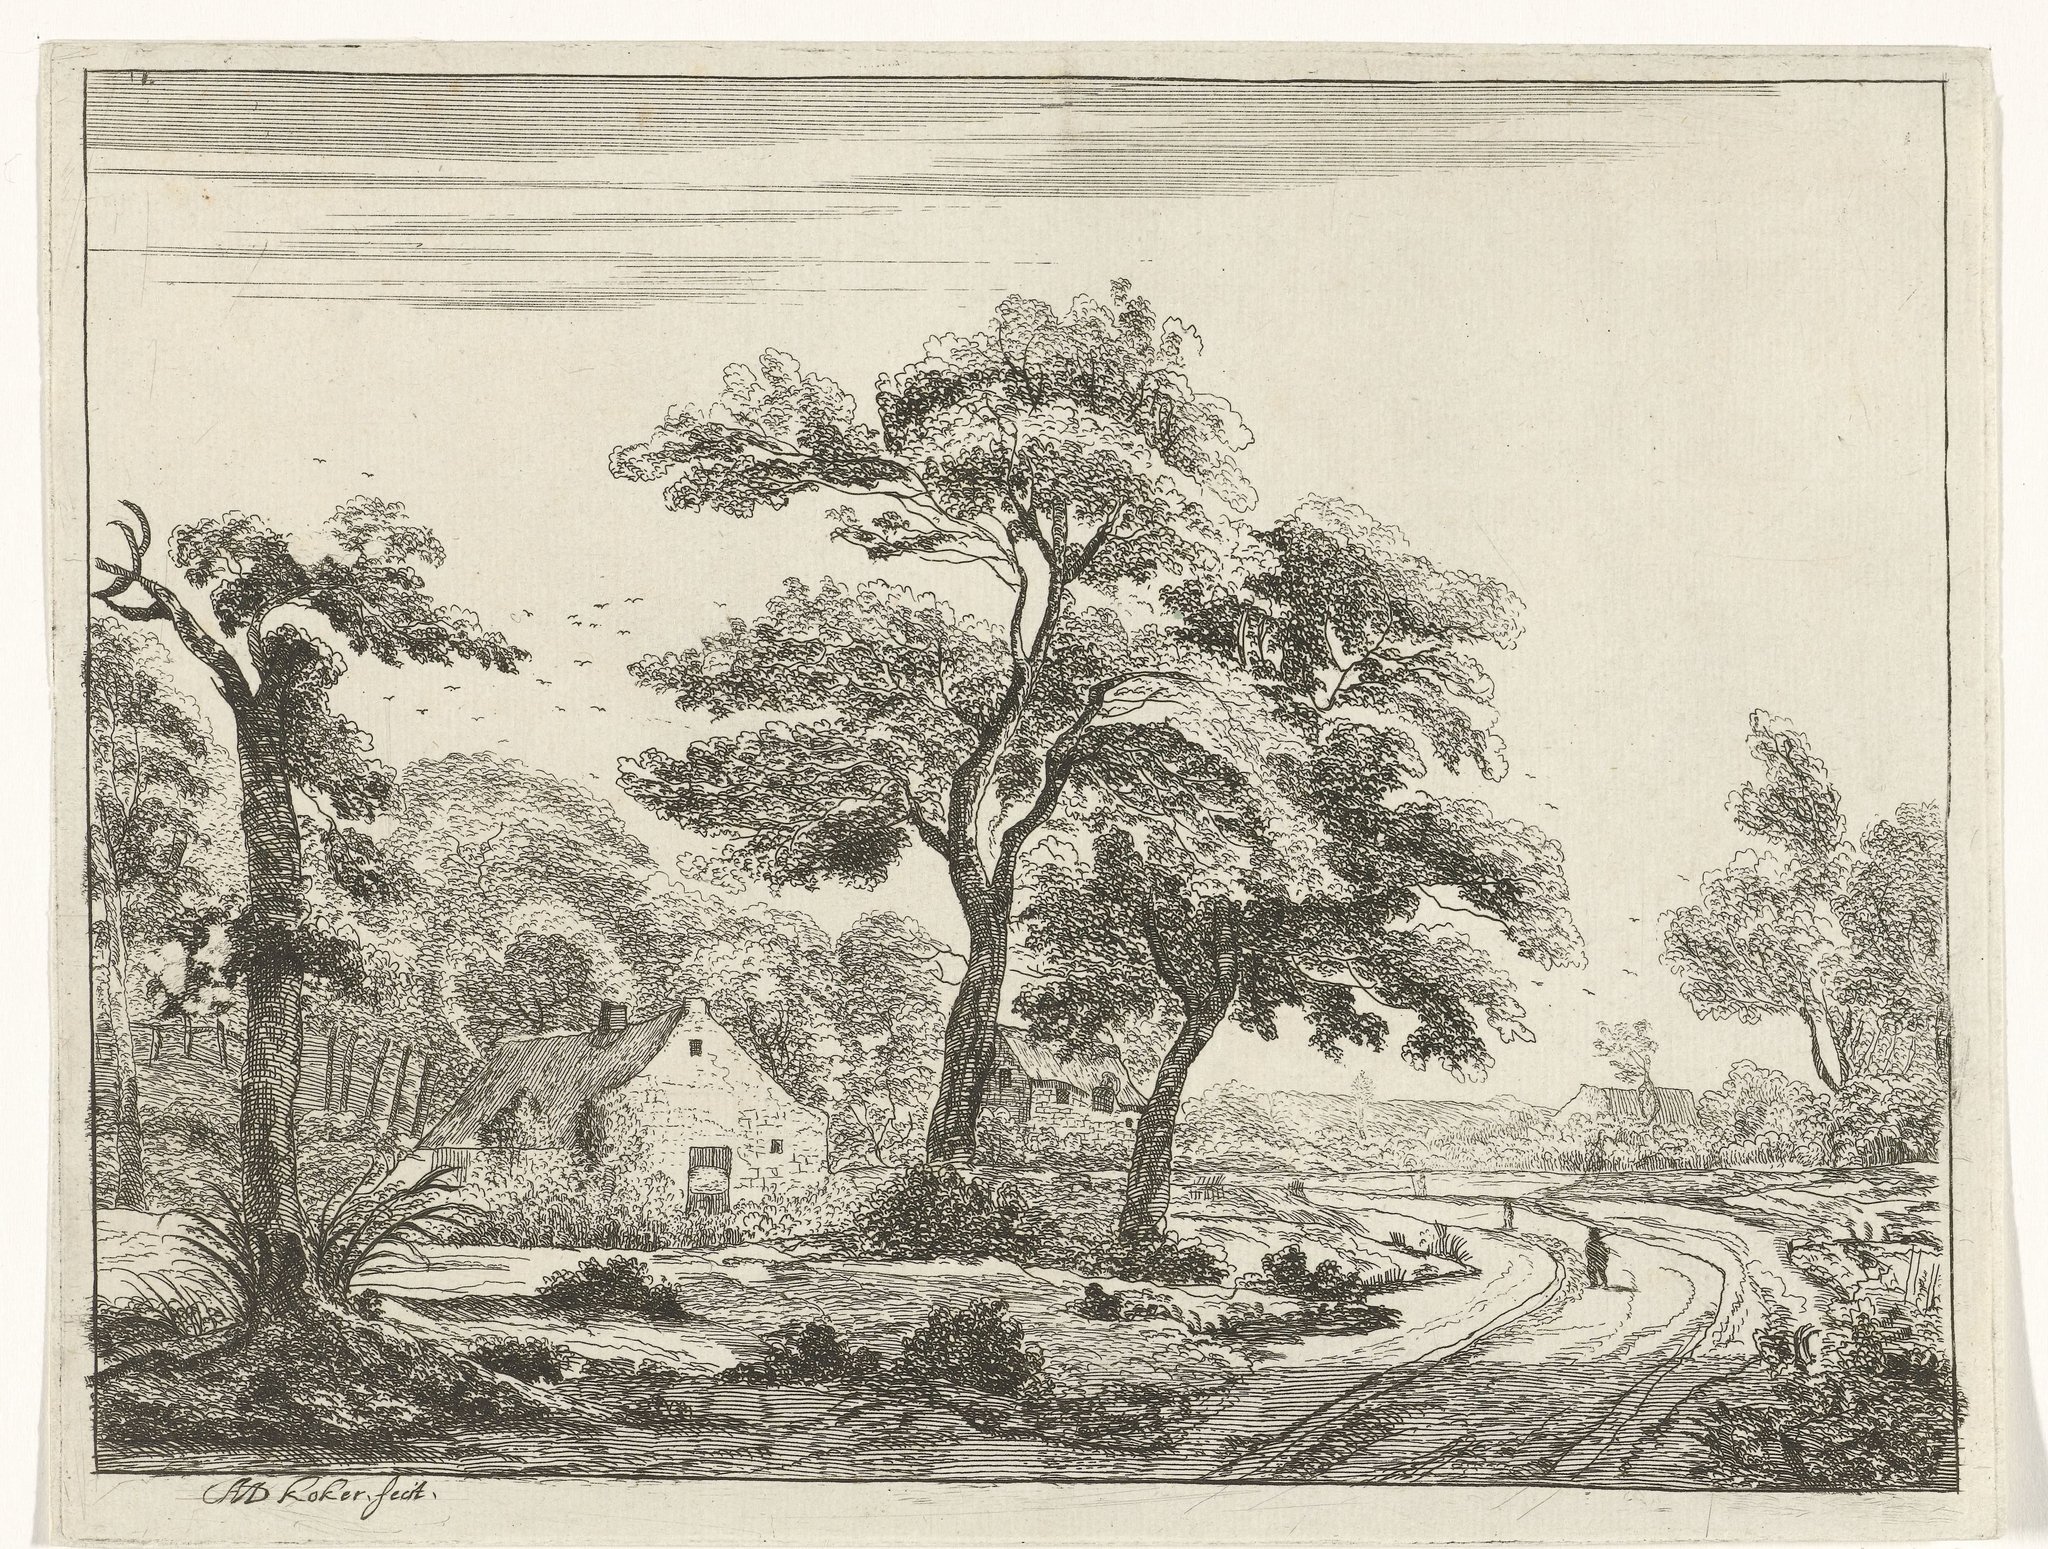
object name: print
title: Gezicht op een dorp met een boerderij in het midden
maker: anna maria de koker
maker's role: print maker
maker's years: -1698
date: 1640-1698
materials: paper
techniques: etching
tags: trees, walking, hiking (recreation), rural housing, e.g. country-house, villa, cottage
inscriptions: collector's mark: Lugt 240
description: Gezicht op een dorp met een boerderij in het midden. Rechts een landweg met twee wandelaars. Langs de weg en tussen de huizen staan bomen en in de lucht vliegen vogels.